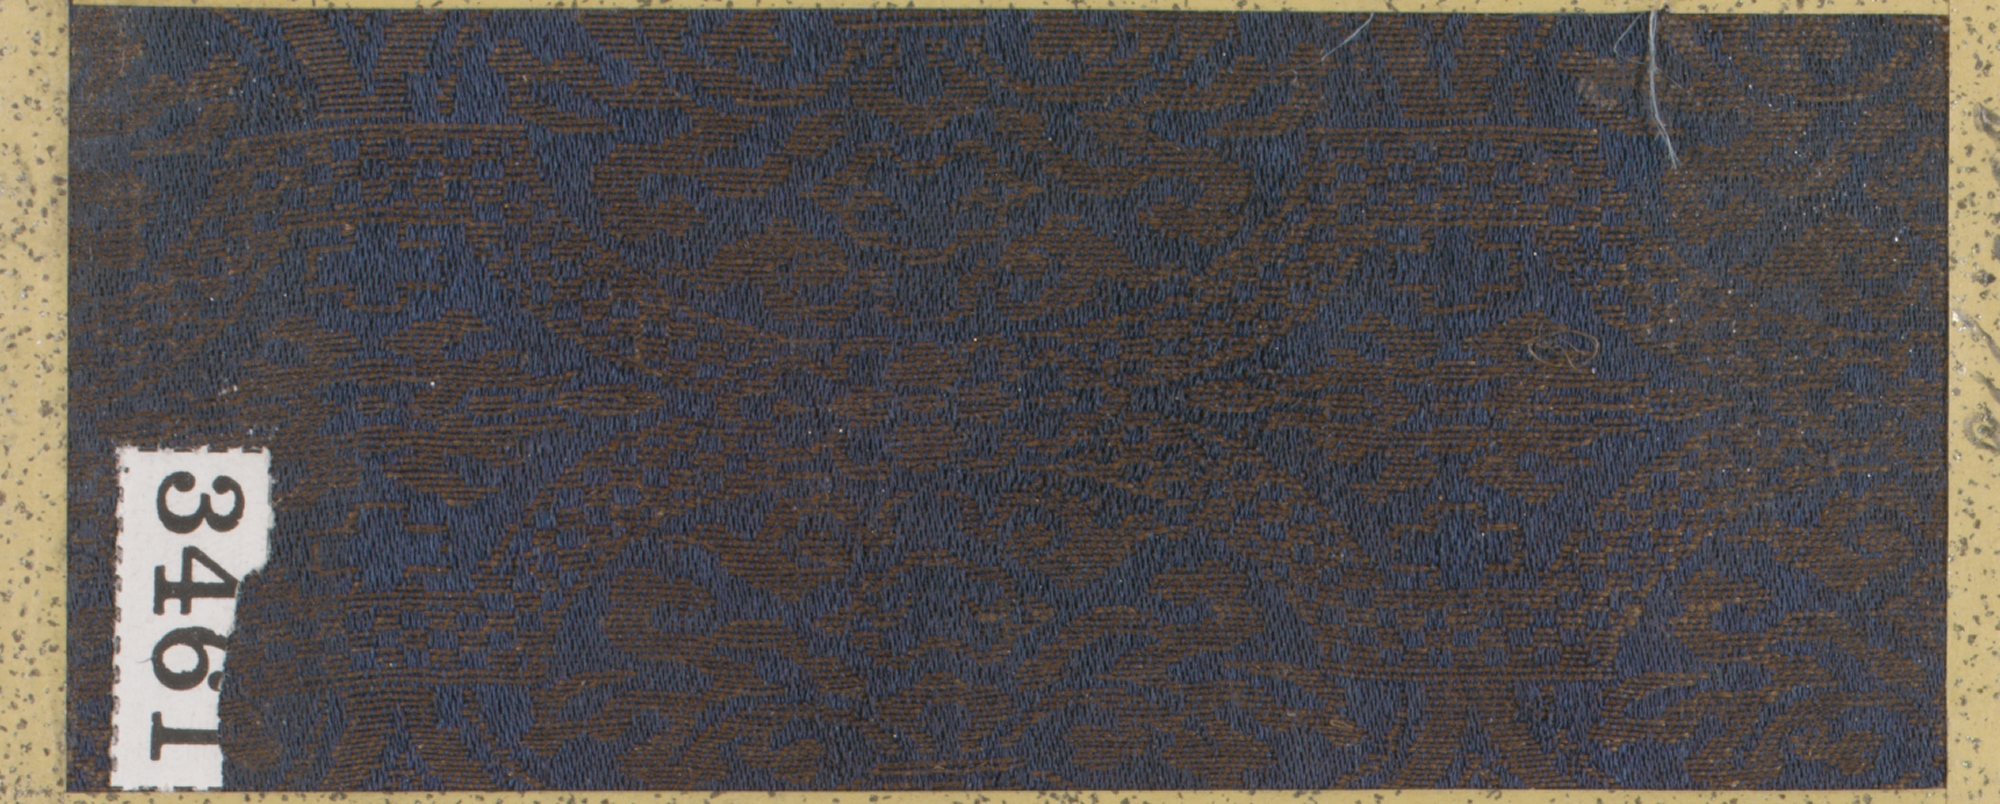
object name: sample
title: Textile Sample from Sample Book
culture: japanese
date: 1801-1900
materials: silk